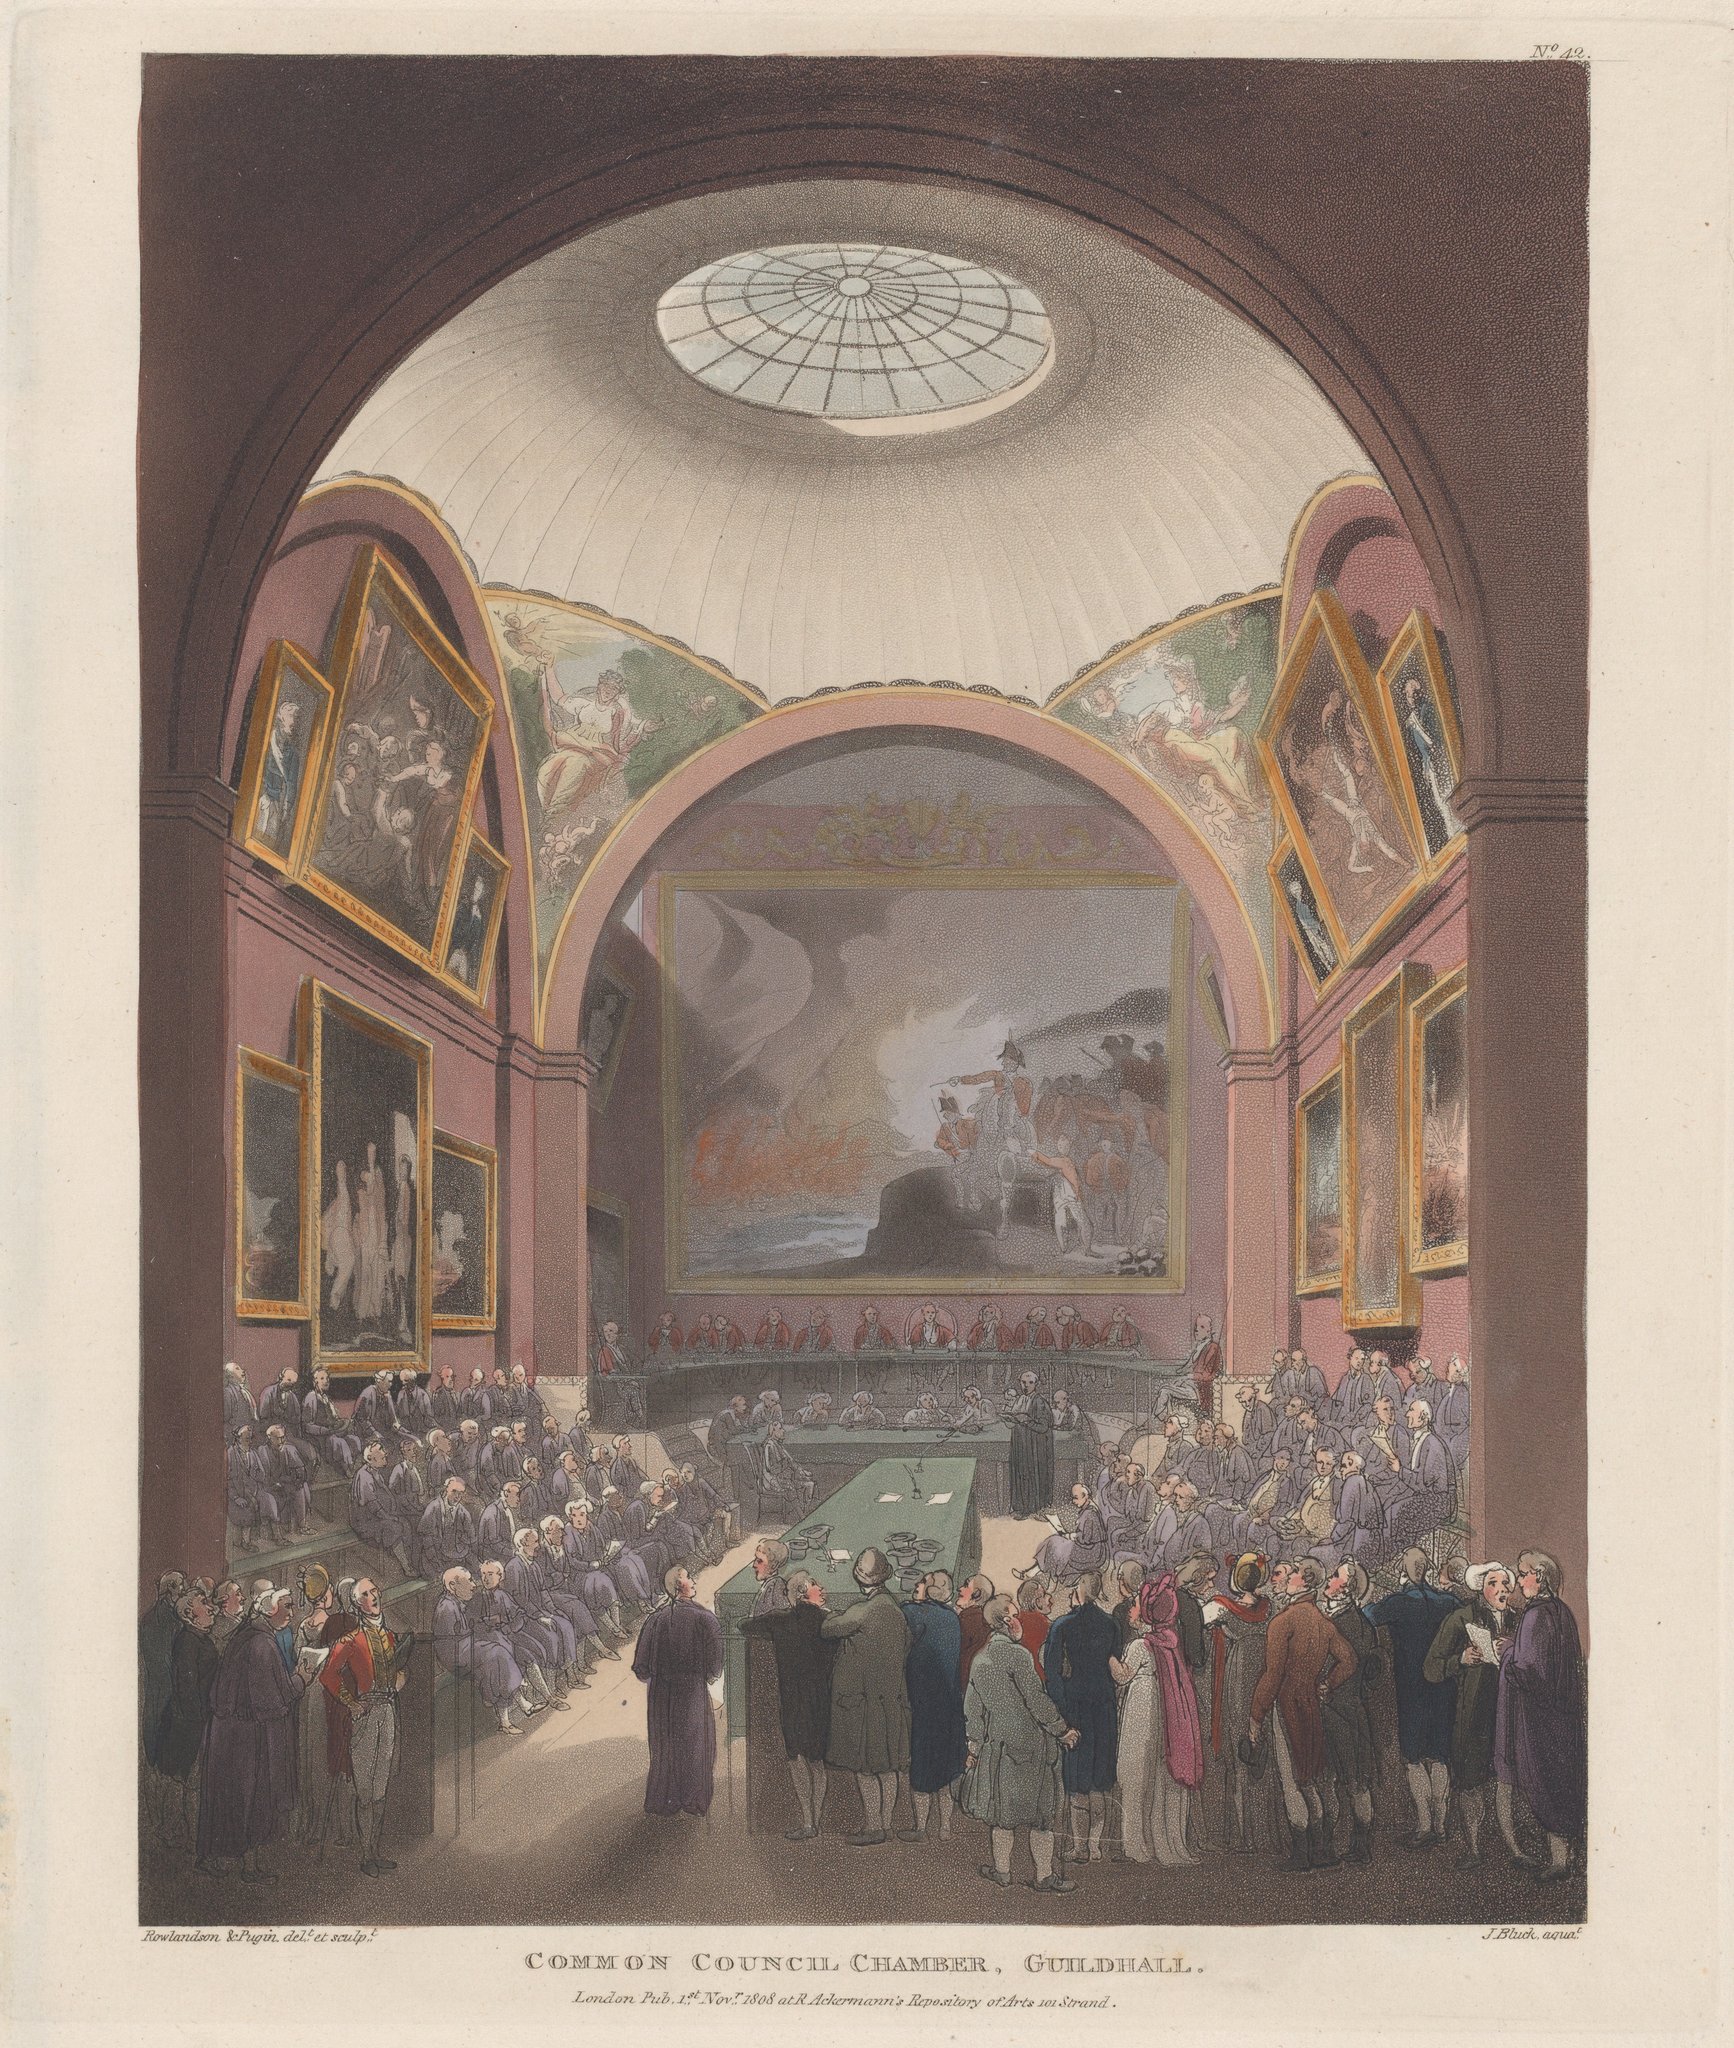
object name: print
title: Common Council Chamber, Guildhall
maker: thomas rowlandson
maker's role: artist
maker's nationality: british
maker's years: 1757-1827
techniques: aquatint, etching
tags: interiors